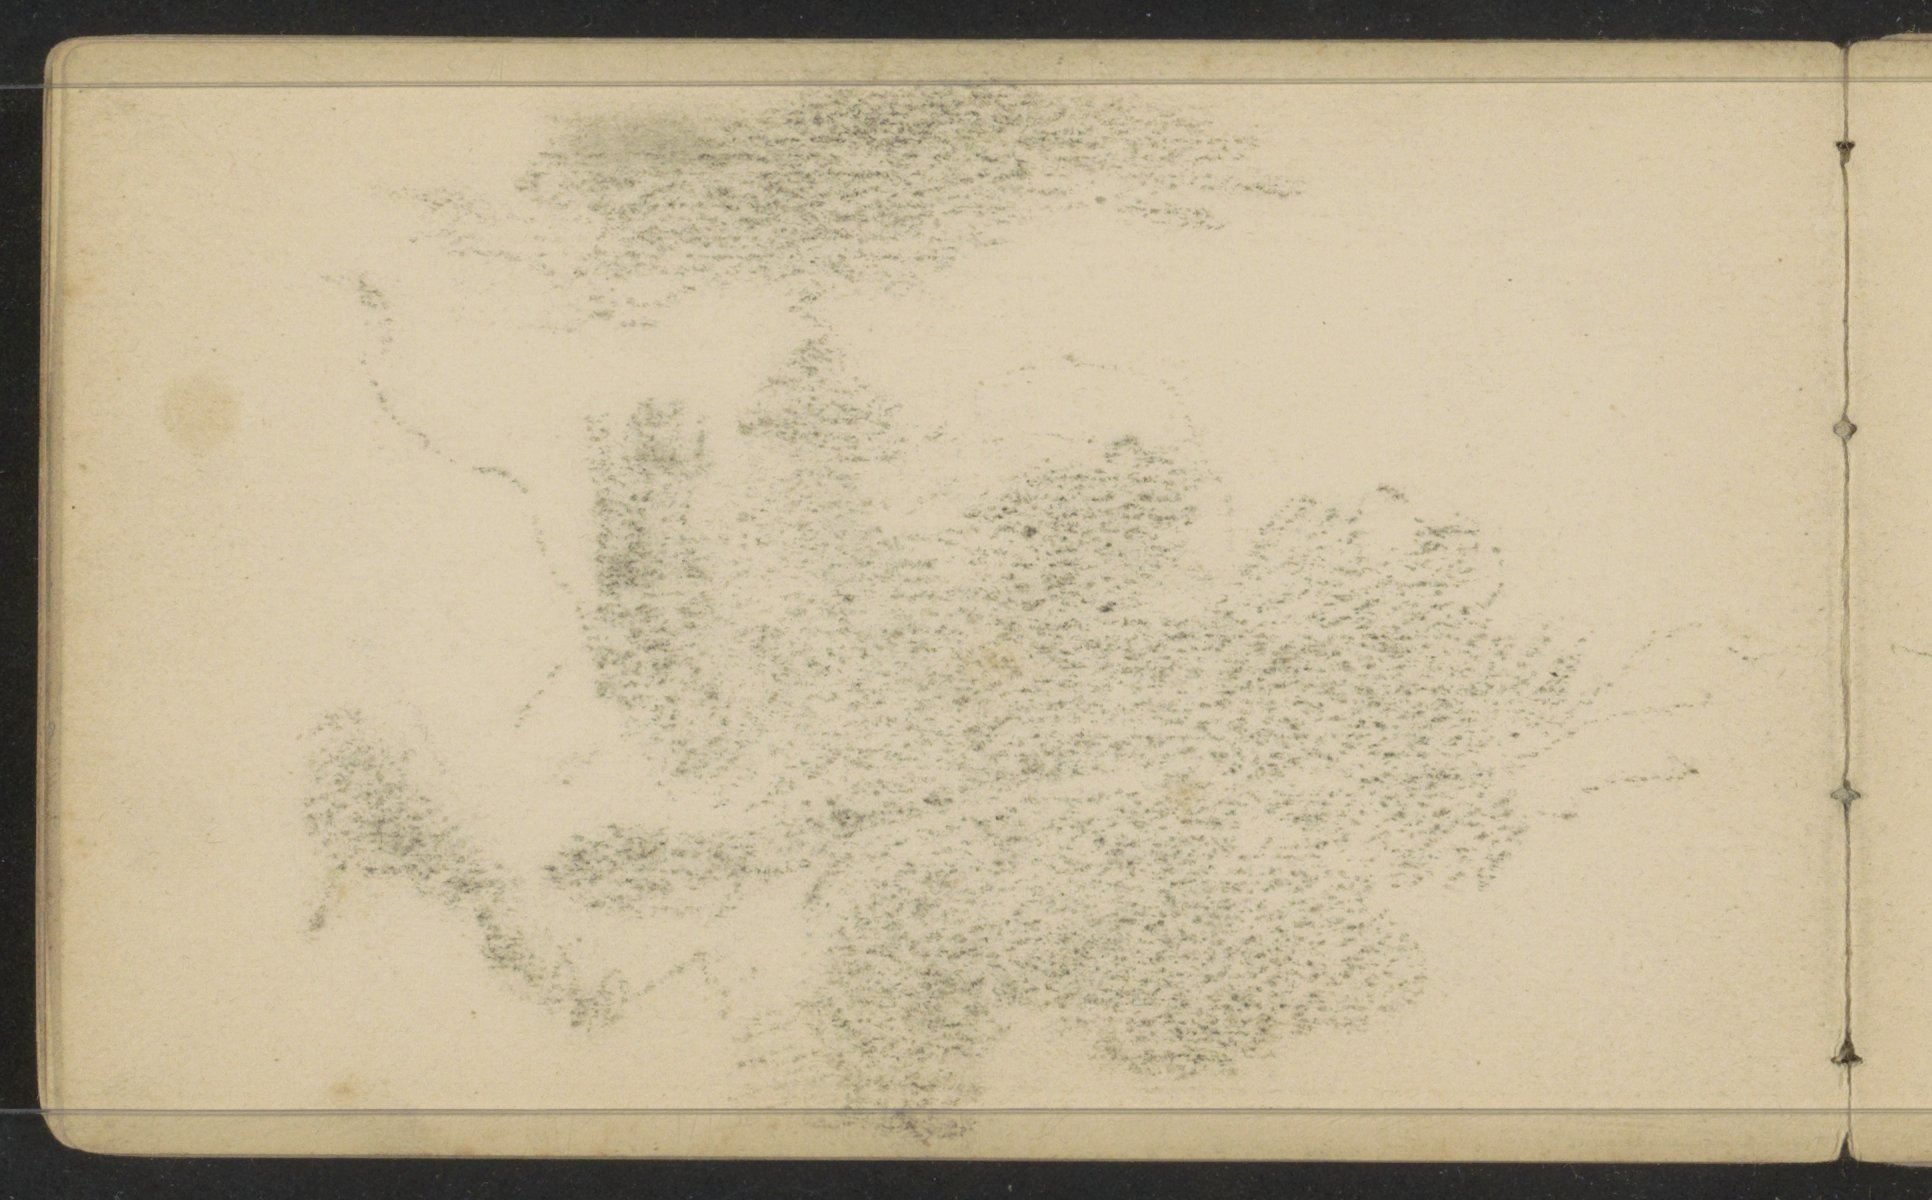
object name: sketchbook leaf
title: Abklatsch van de krijttekening op blad 12 recto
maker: willem cornelis rip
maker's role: draughtsman, painter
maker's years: 1856-1922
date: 1892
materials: paper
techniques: printmaking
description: Blad 11 verso uit een schetsboek met 25 bladen.